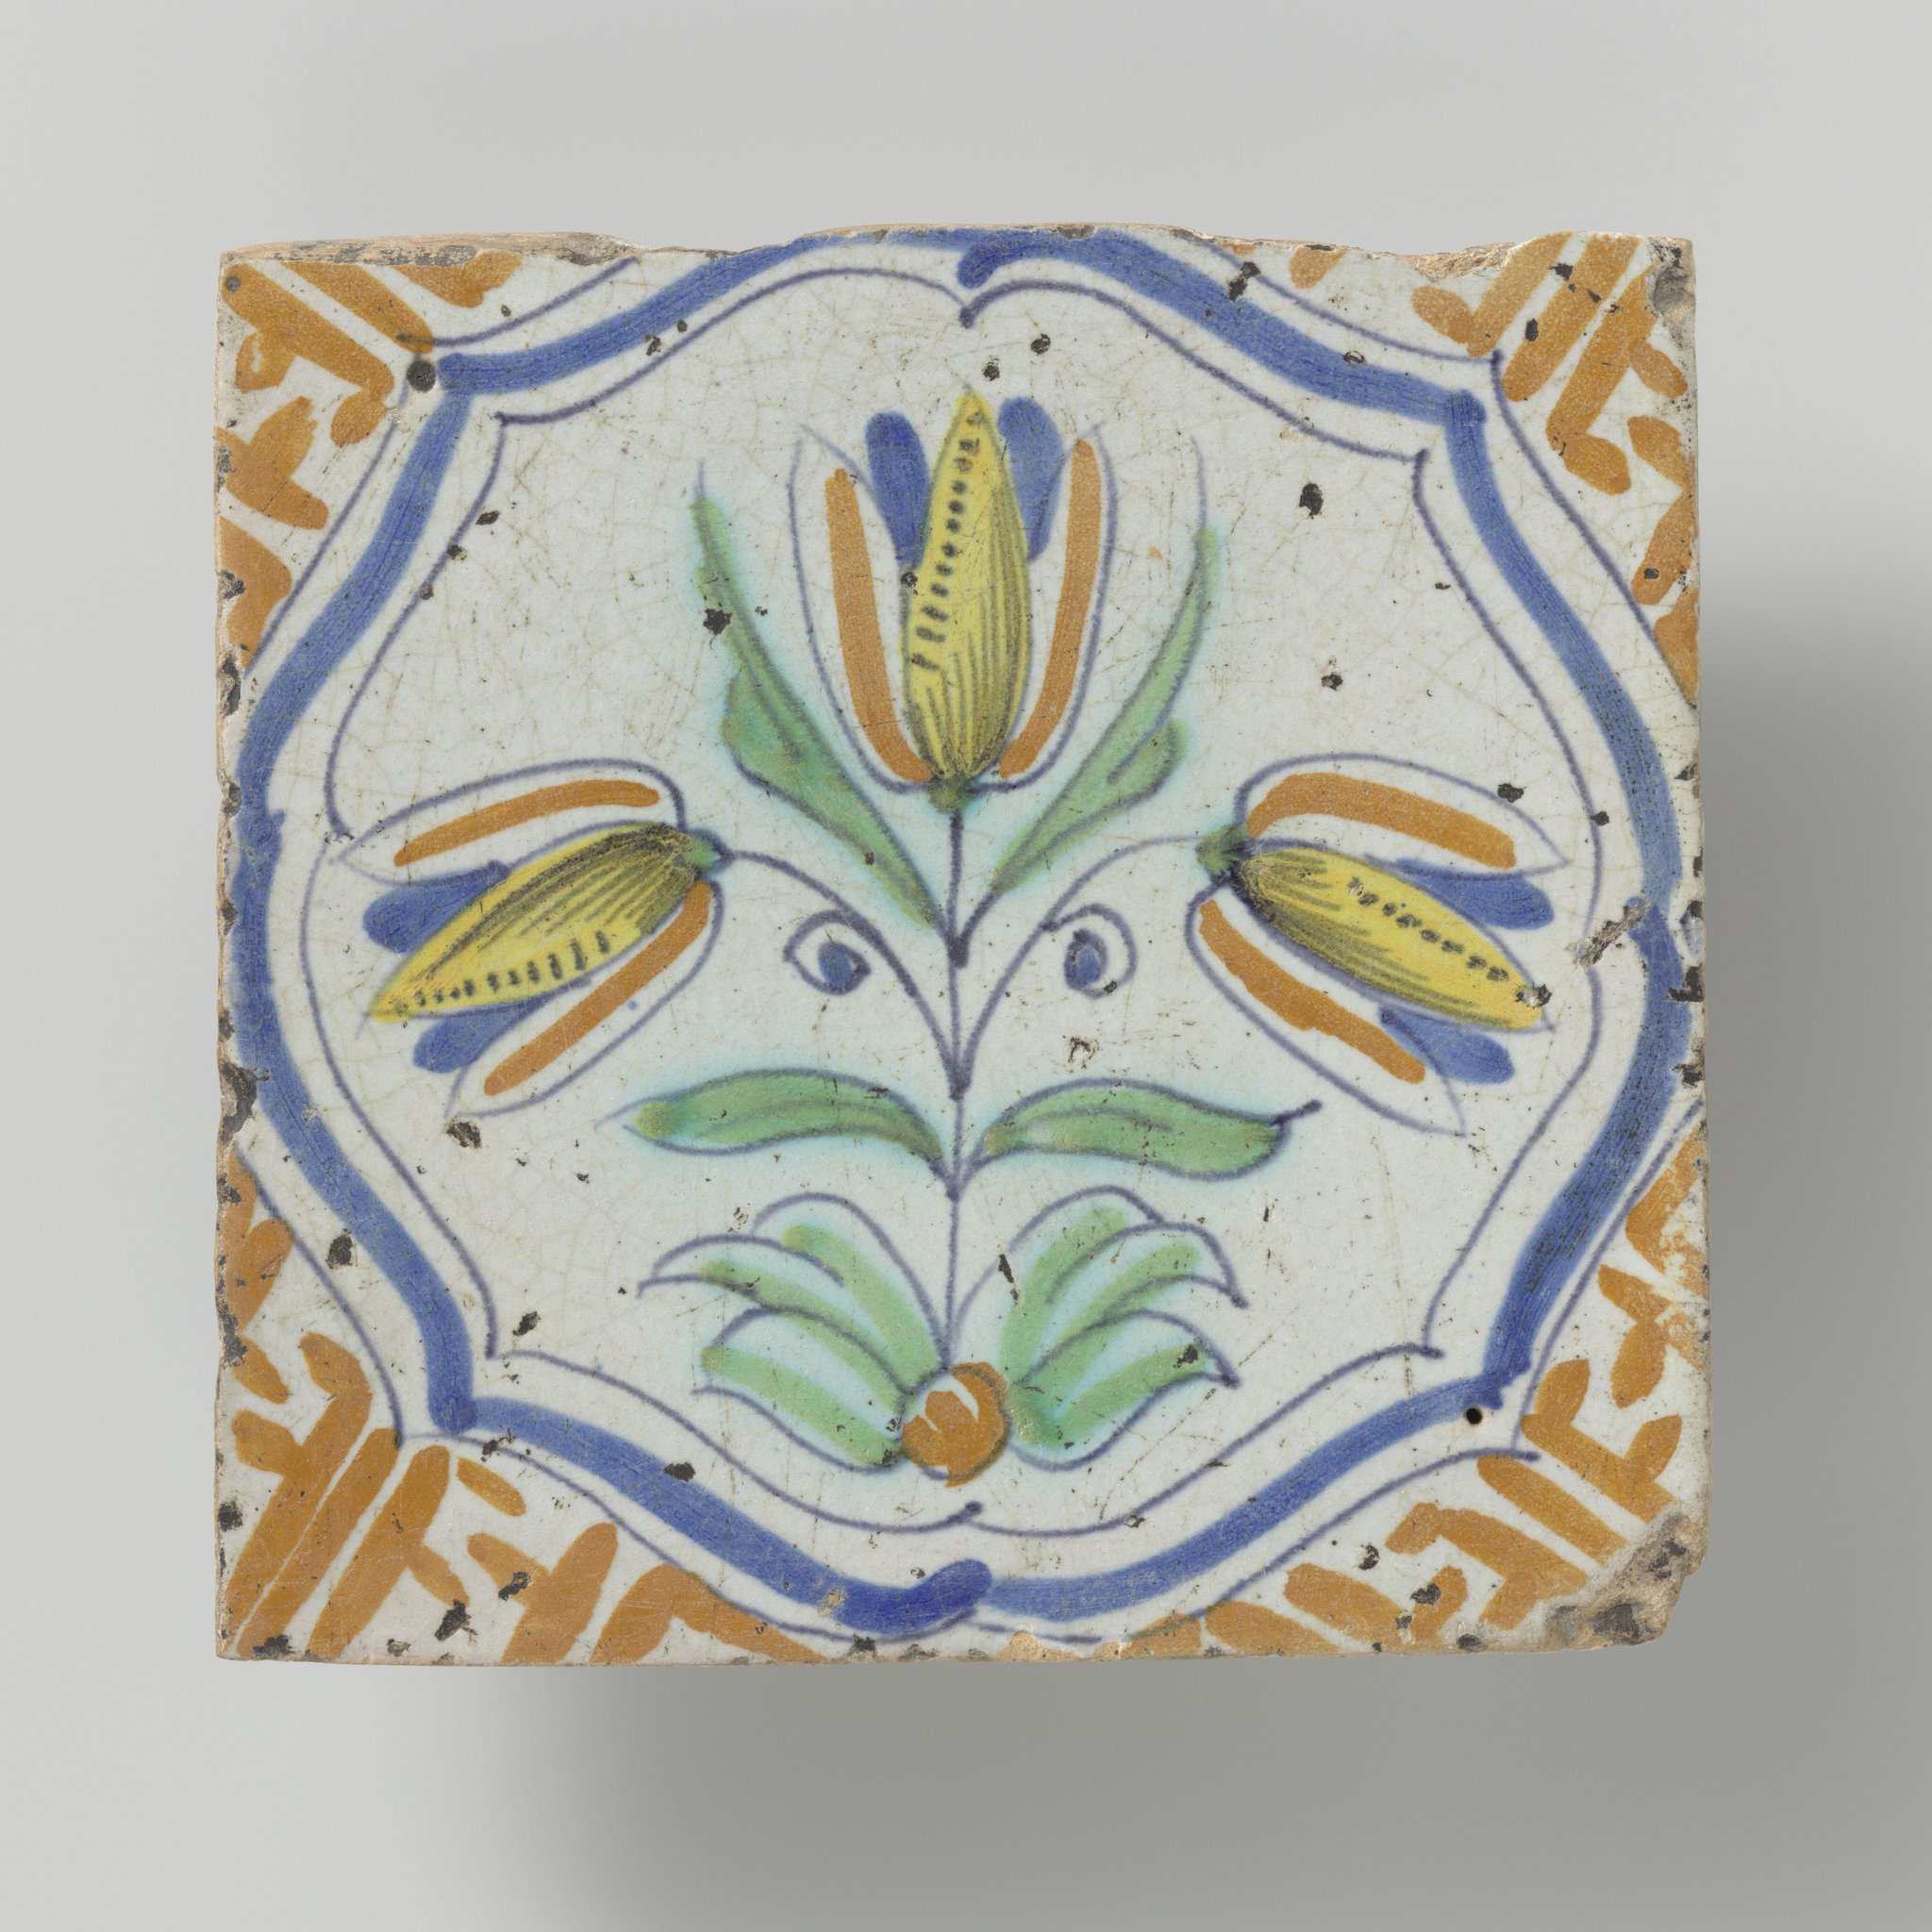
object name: tile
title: Tegel met drietulp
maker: Anonymous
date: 1620-1660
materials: earthenware, glaze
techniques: maiolica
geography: netherlands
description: Tegel met een veelkleurig (blauw, oranje, groen, geel en paars) geschilderde drietulp omlijst door een akkolade met in de hoeken, meanderornament.